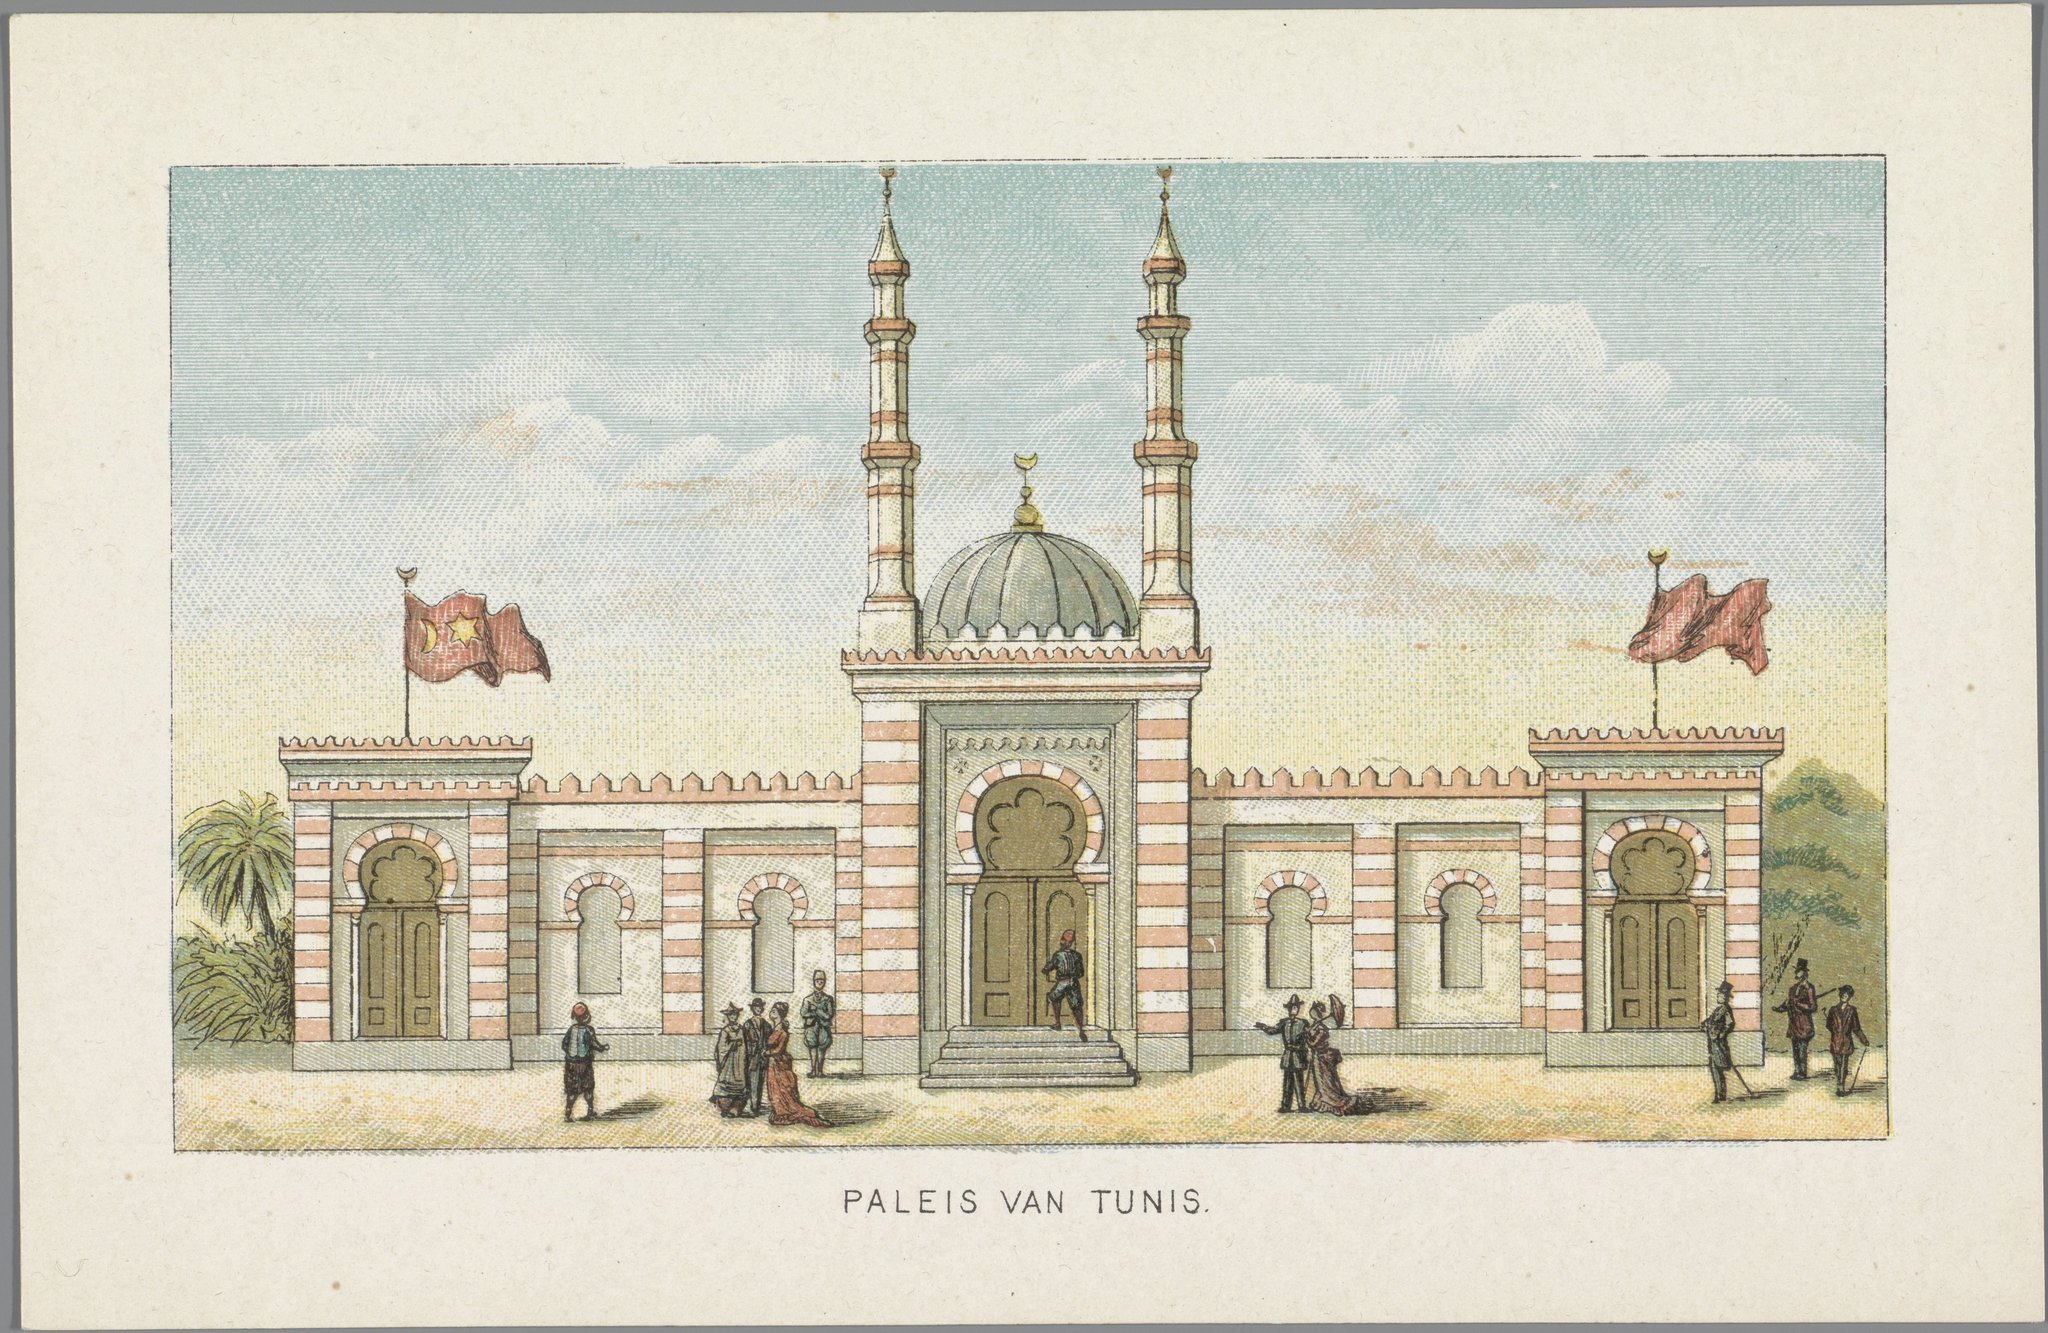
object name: print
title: Paleis van Tunis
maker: Anonymous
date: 1883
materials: paper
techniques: chromolithography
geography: amsterdam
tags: world fair, world exhibition, amsterdam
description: Het Paleis van Tunis op de Wereldtentoonstelling op het Museumplein te Amsterdam. Onderdeel van een groep van zestien platen en een plattegrond van de Wereldtentoonstelling in Amsterdam van 1 mei tot 1 oktober 1883. Uitgave van het Nieuws van den Dag.